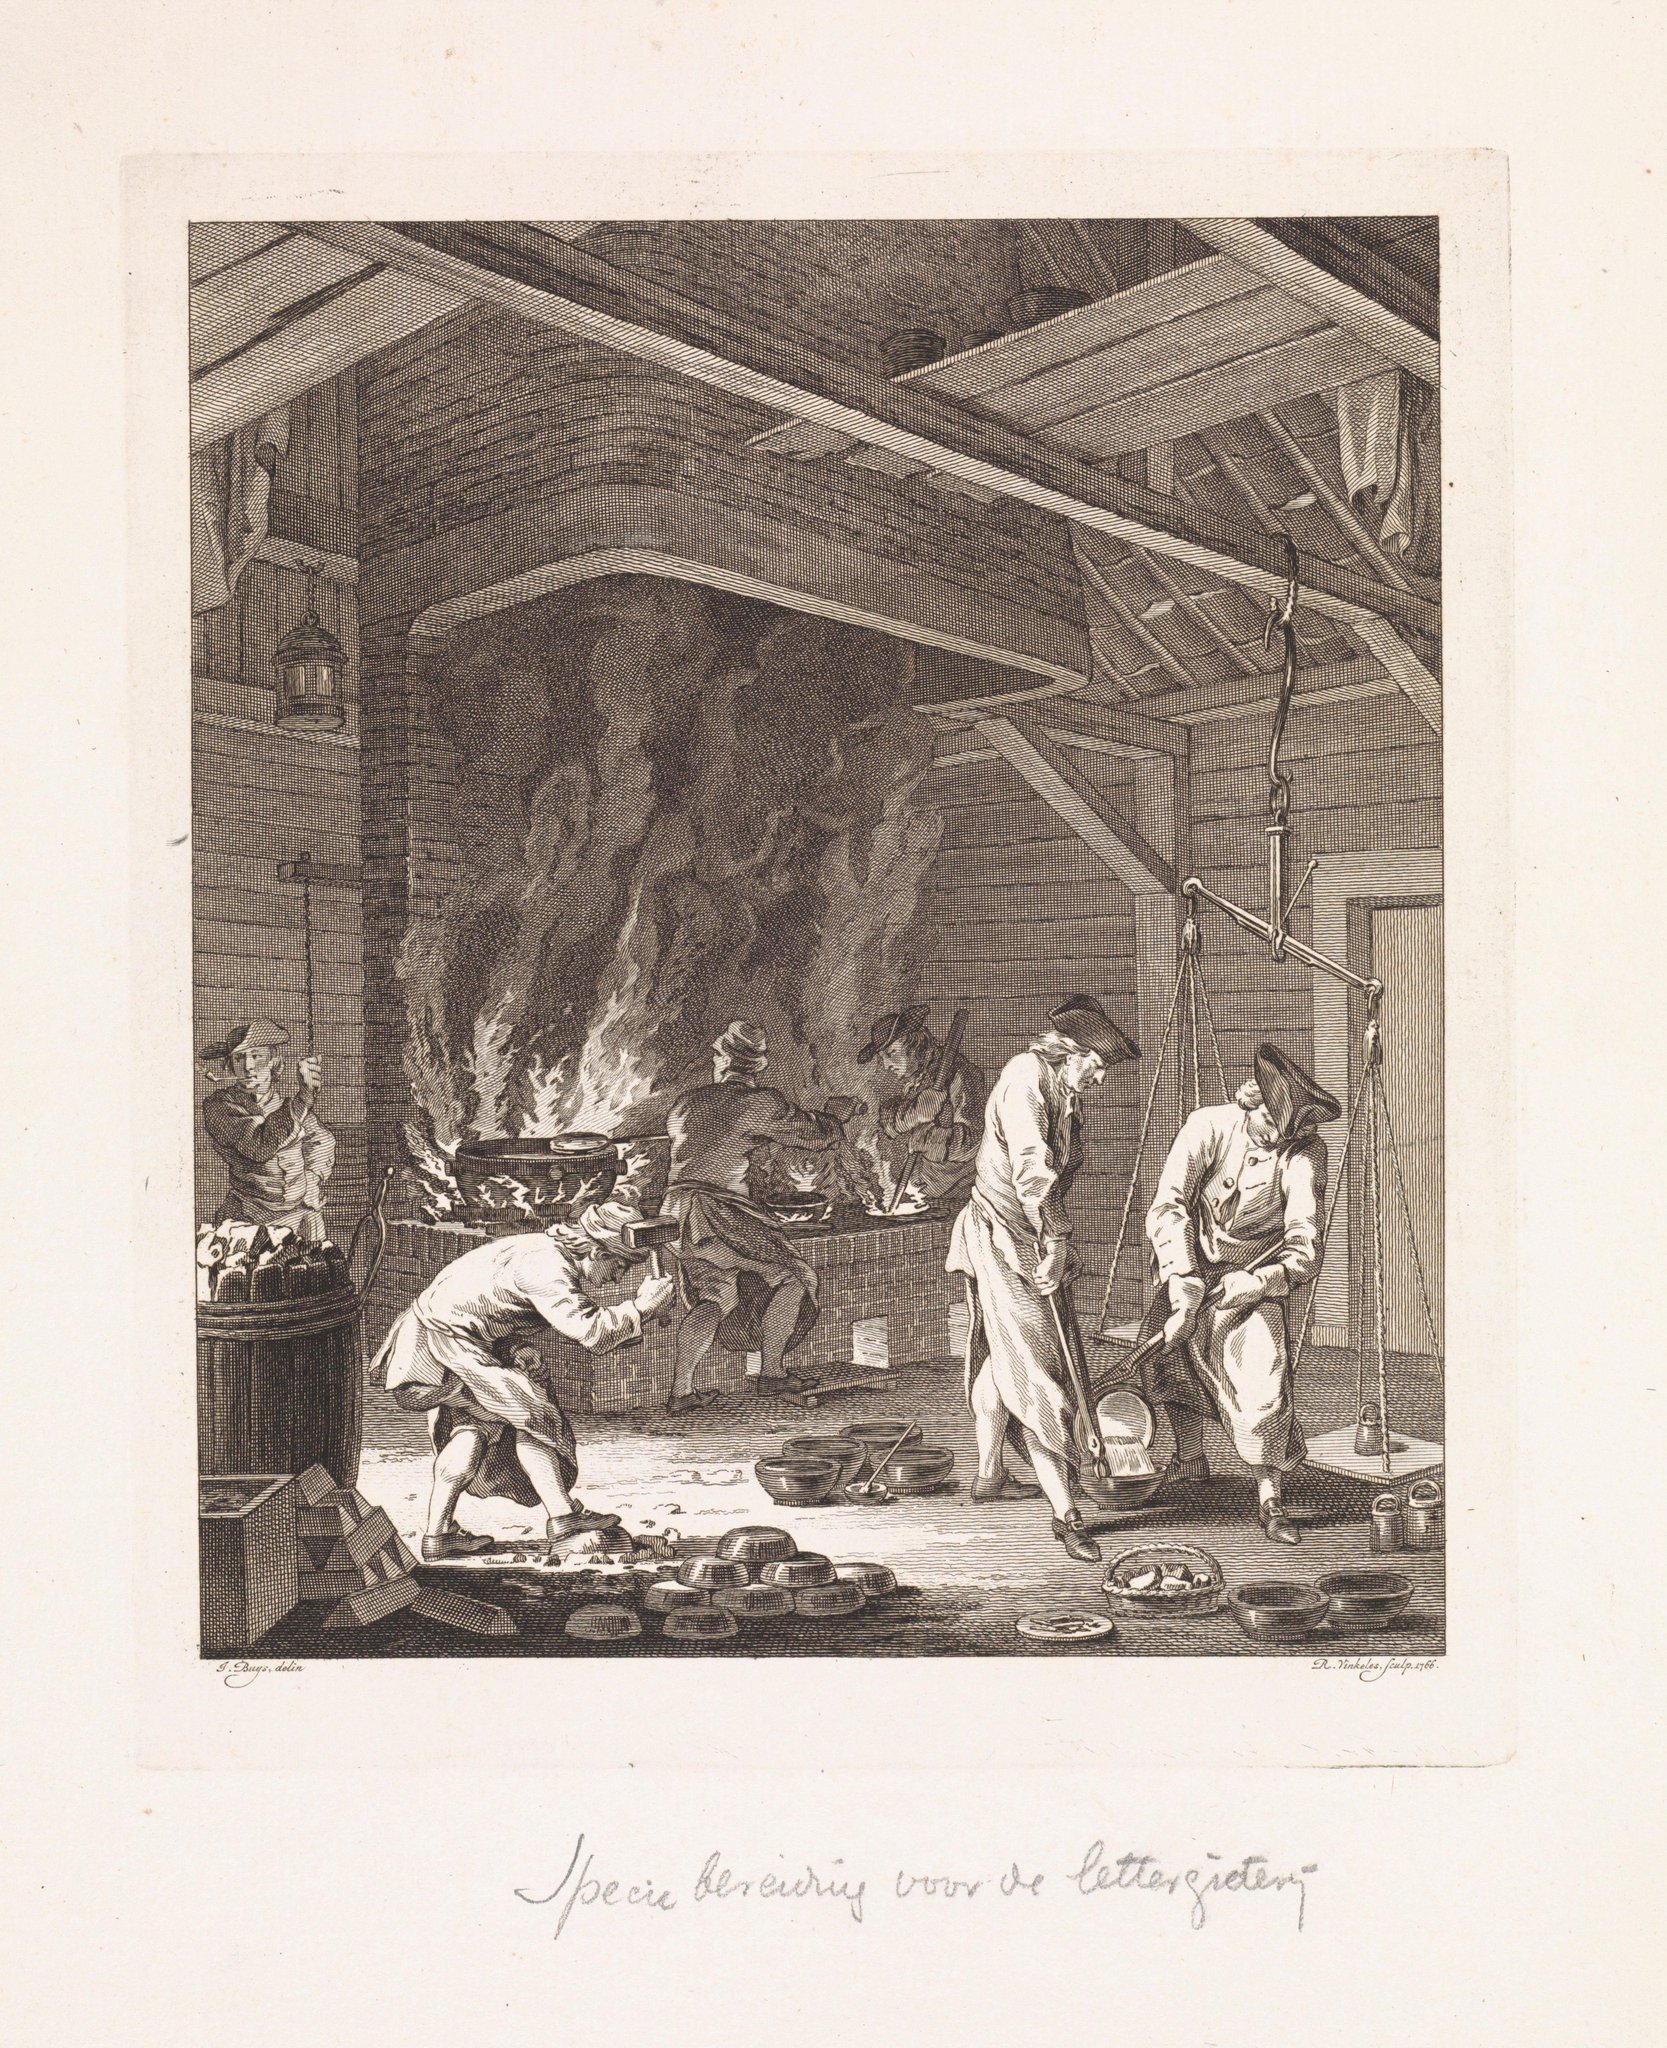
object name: print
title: Lettergieterij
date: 1766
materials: paper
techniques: engraving, etching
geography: amsterdam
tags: publishing, publisher (+ in workshop, laboratory), printing, printing office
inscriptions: collector's mark: Lugt 240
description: In een lettergieterij zijn zes mannen loden letters aan het fabriceren. Op de voorgrond gieten twee mannen lood in een mal. Op de achtergrond wordt het lood verhit.